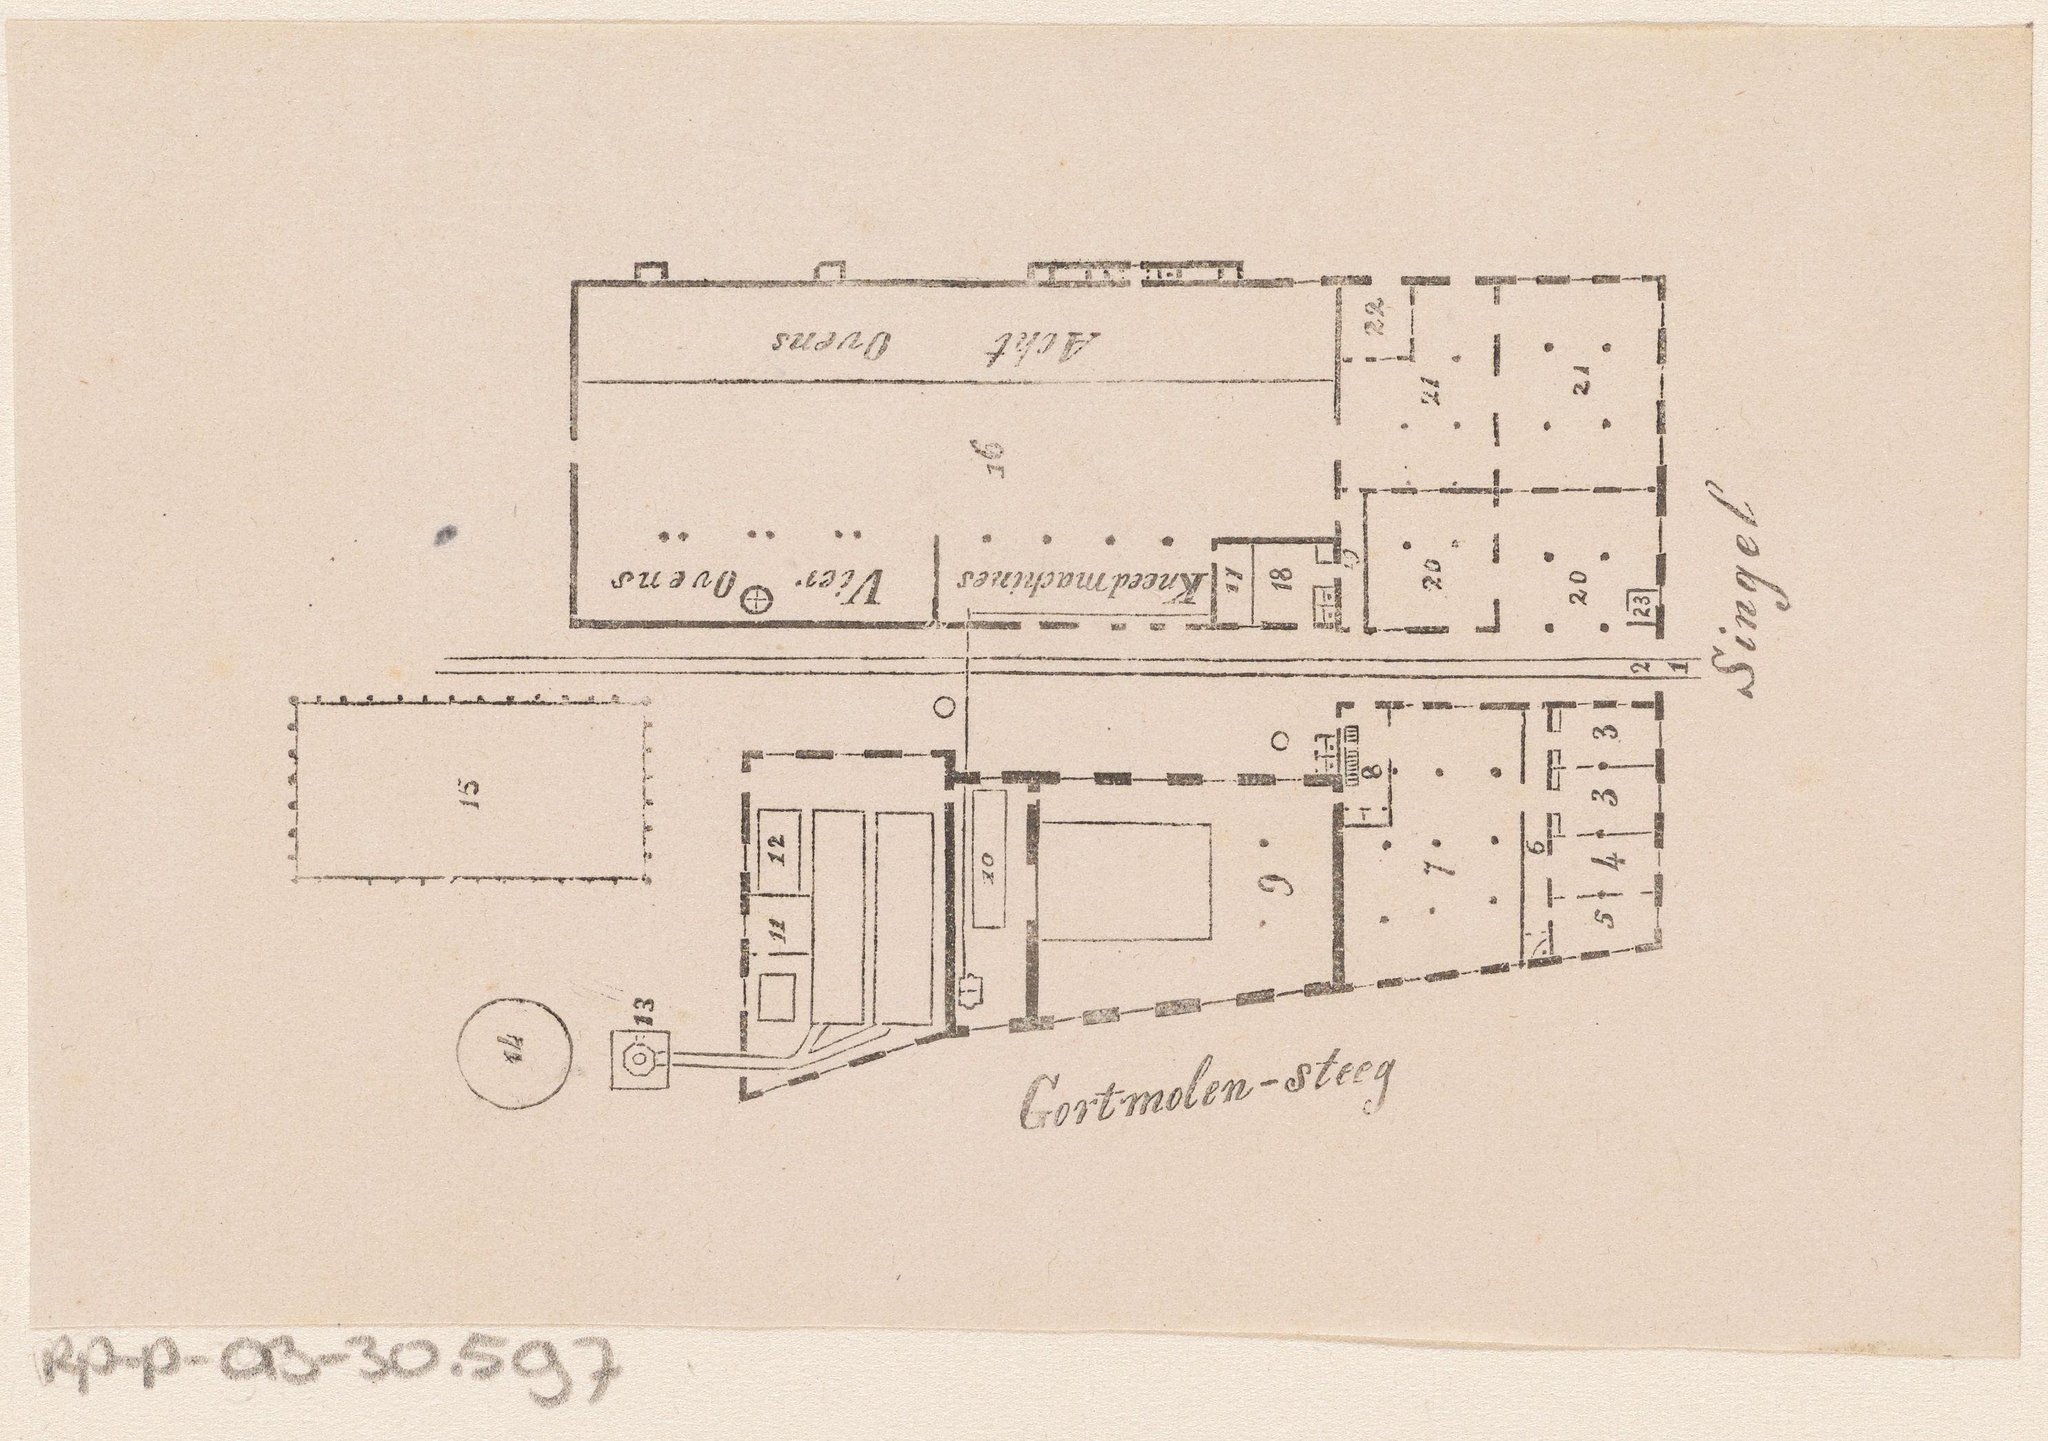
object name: print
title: Plattegrond van een bedrijf met meerdere ovens en kneedmachines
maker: isaac weissenbruch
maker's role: print maker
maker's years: 1826-1912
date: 1836-1912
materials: paper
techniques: engraving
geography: netherlands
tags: preparing dough or batter, fire, oven, furnace ~ interior of industrial structure, plan ~ architecture